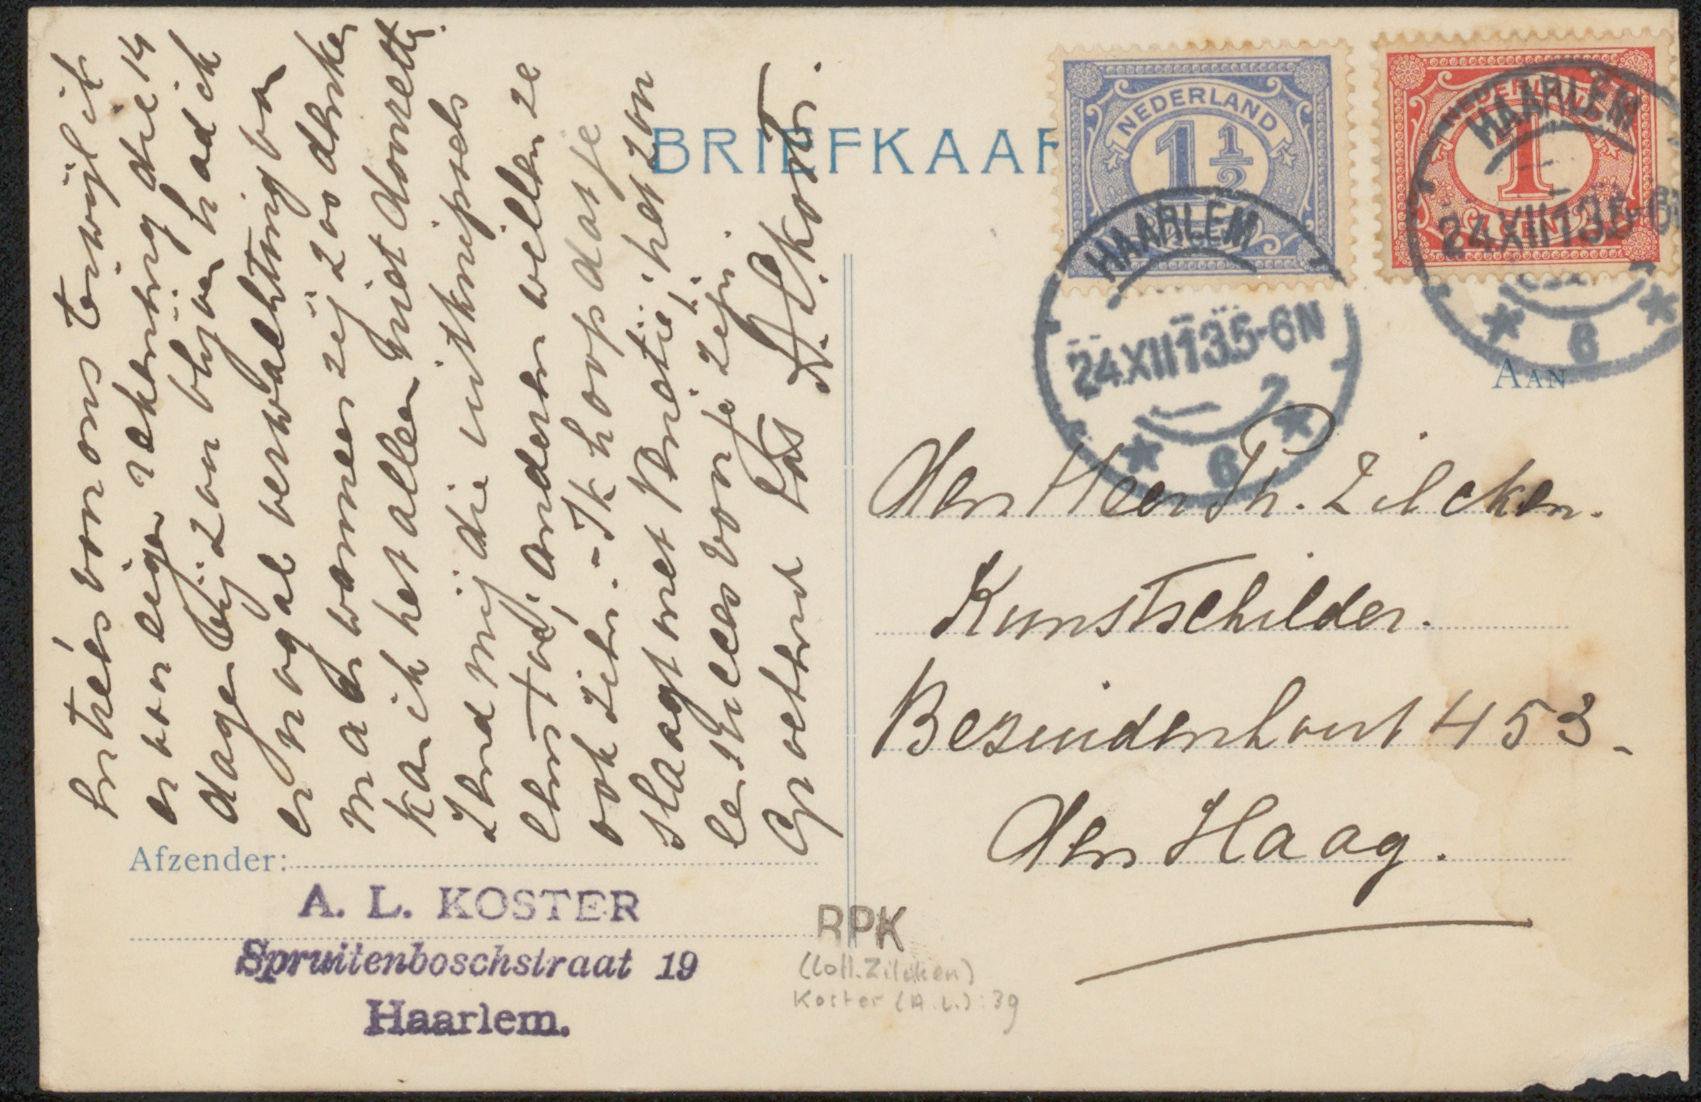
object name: postcard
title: Briefkaart aan Philip Zilcken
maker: anton l. koster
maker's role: draughtsman, painter, print maker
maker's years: 1859-1937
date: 1913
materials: cardboard, ink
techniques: pen, writing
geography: haarlem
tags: carl august breitenstein, willy sluiter, the hague, painter, philip zilcken, money, venice, amsterdam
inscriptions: collector's mark: ‘RPK’, address: ‘A.L. KOSTER/ Spruitenboschstraat 19/ Haarlem.’